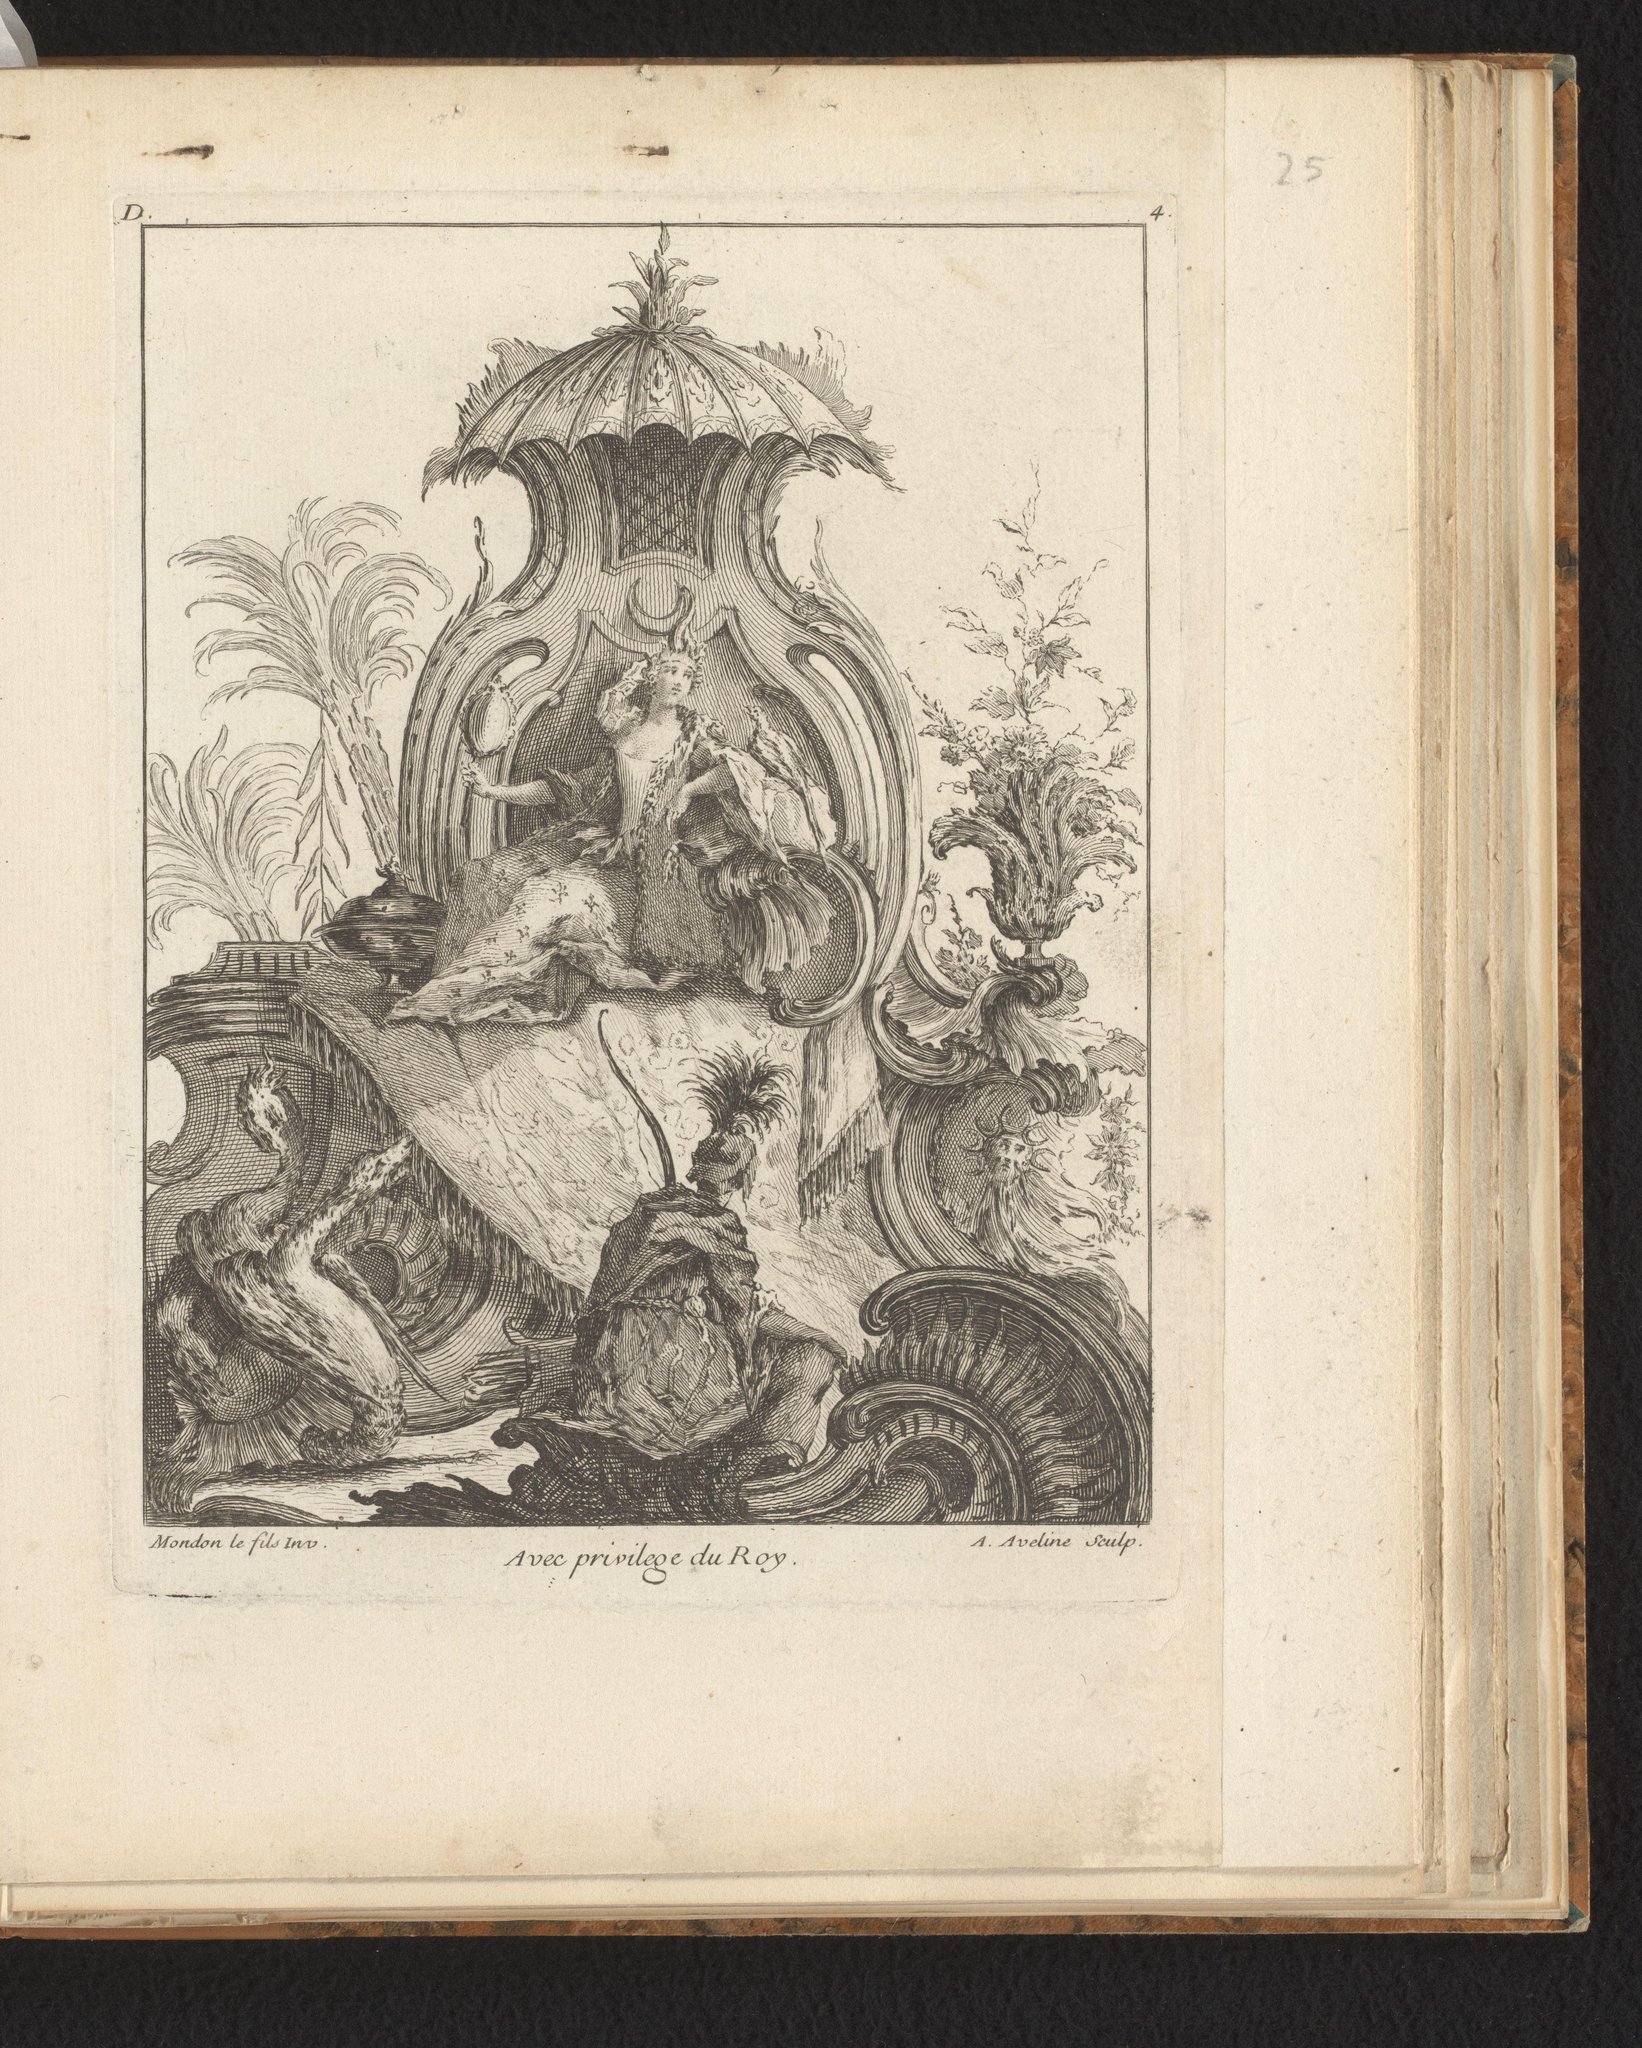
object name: album leaf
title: Vierde serie rocailles, figuren en Chinese draken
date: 1736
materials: paper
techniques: etching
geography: france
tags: rocaille ornament, throne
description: Deze serie is linksboven genummerd met een letter D. Prent maakt deel uit van een album.